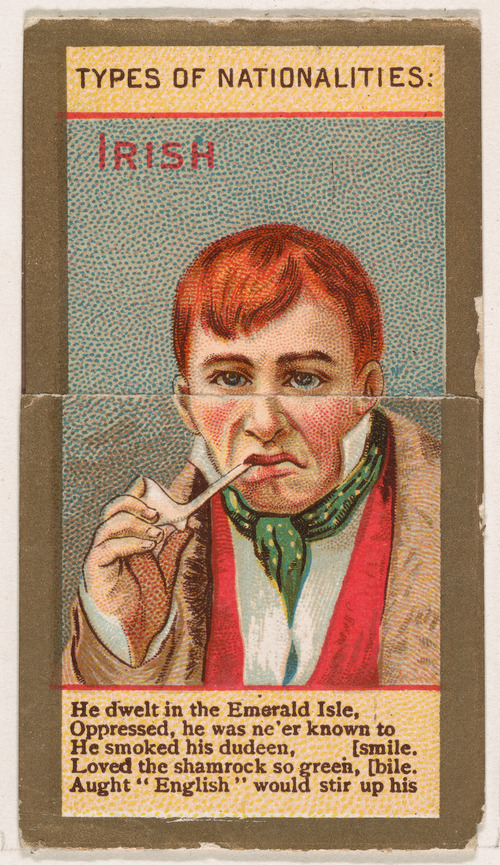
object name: print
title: Irish, from Types of Nationalities (N240) issued by Kinney Bros.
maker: kinney brothers tobacco company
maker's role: publisher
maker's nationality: american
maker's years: 1869-2011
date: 1890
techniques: color lithograph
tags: men,smoking